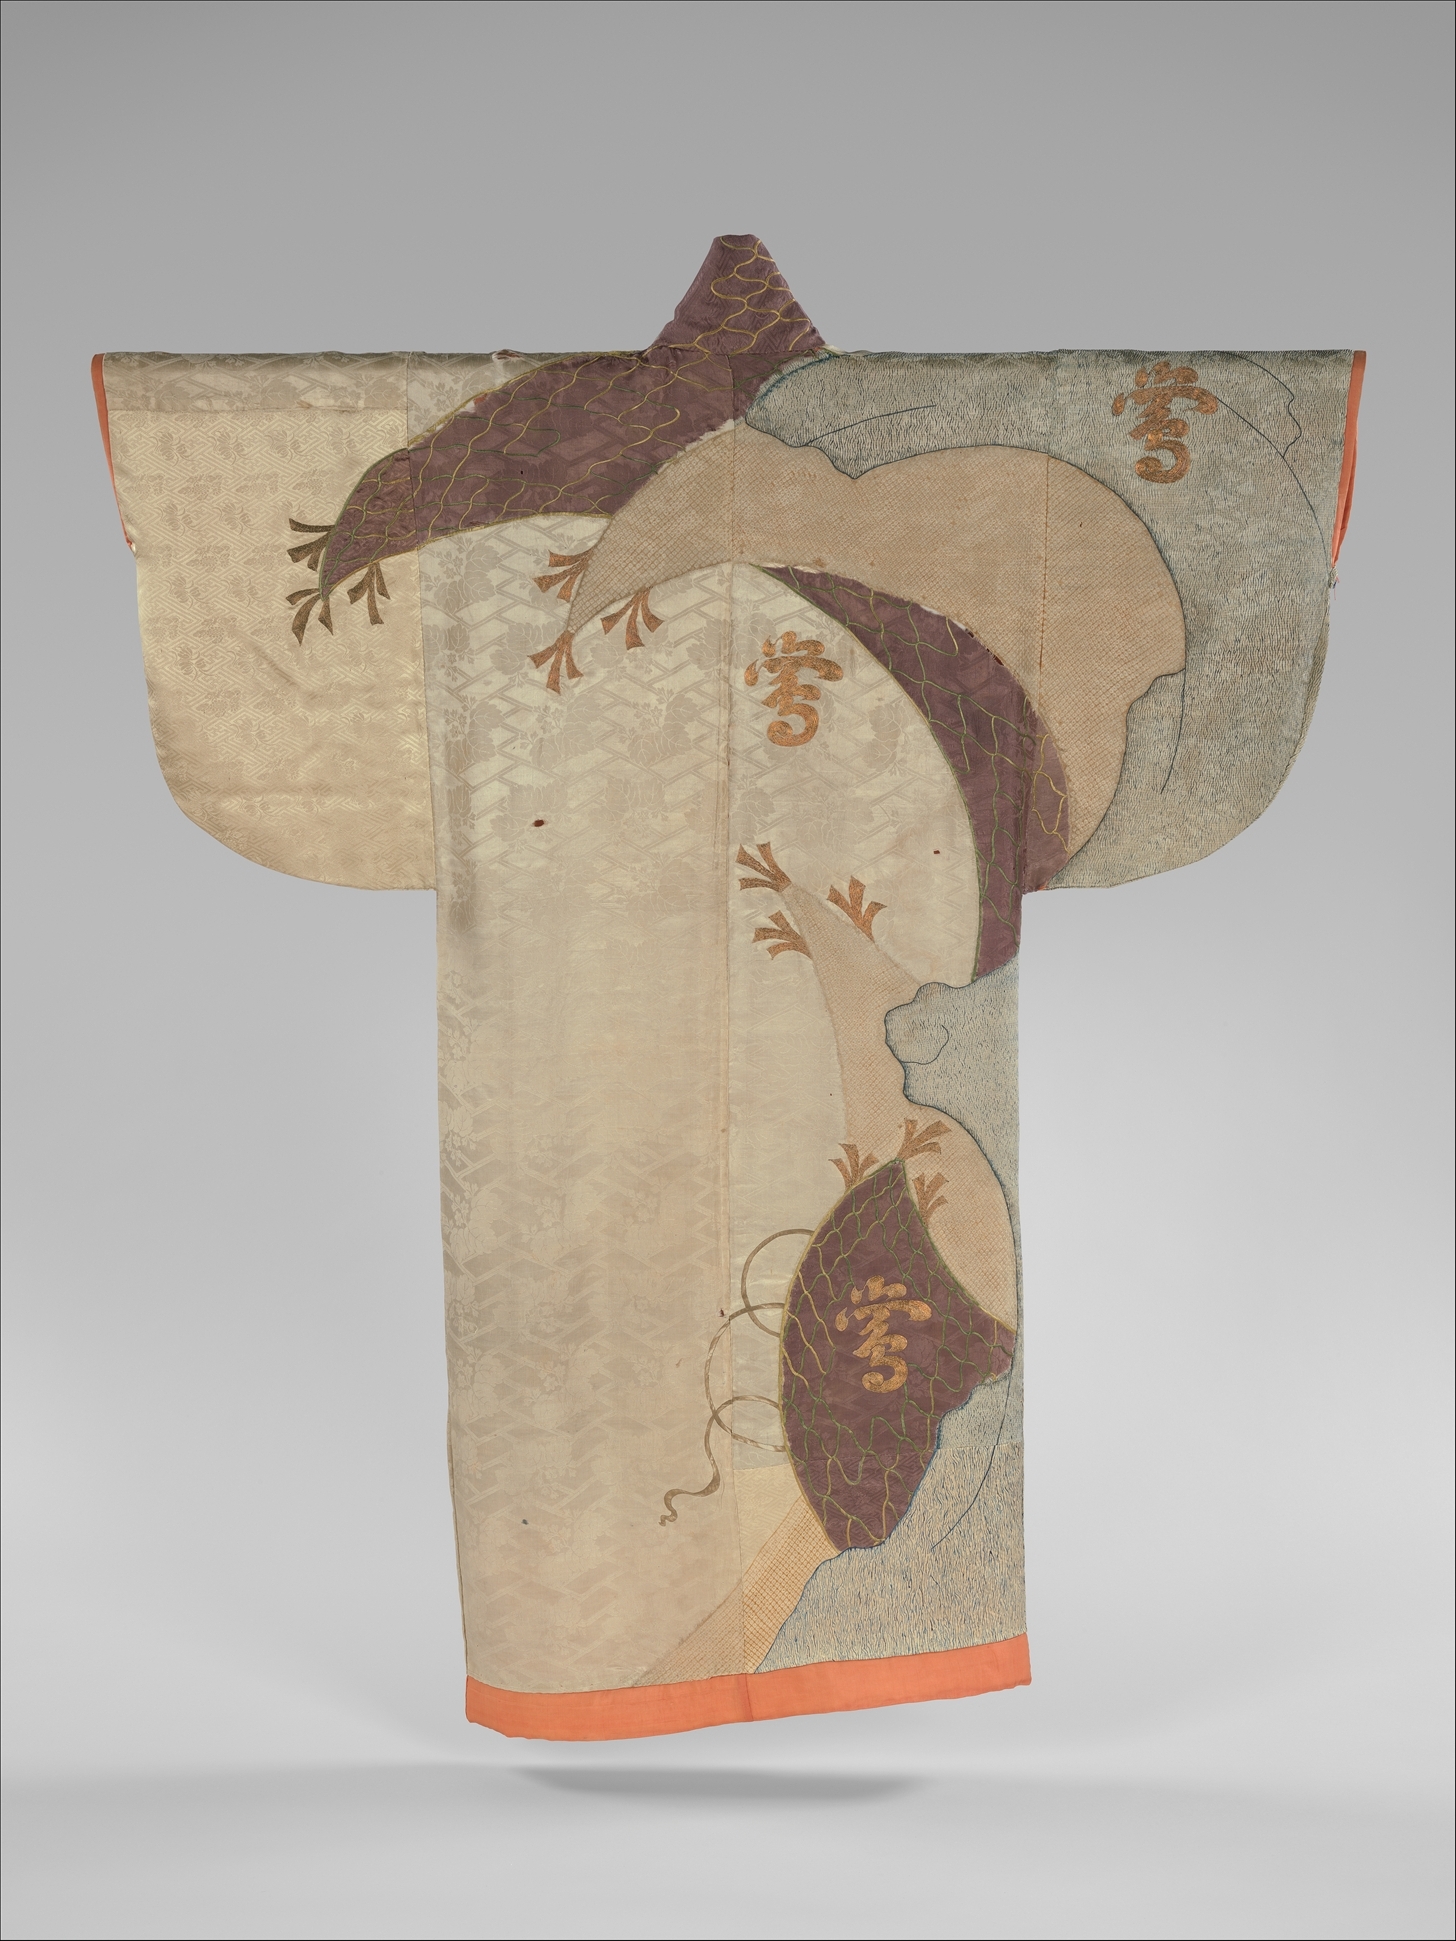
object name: robe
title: Robe (Kosode) with Fishing Net and Characters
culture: japanese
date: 1660-1669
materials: metal thread, textile, silk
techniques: damask, embroidery, resist